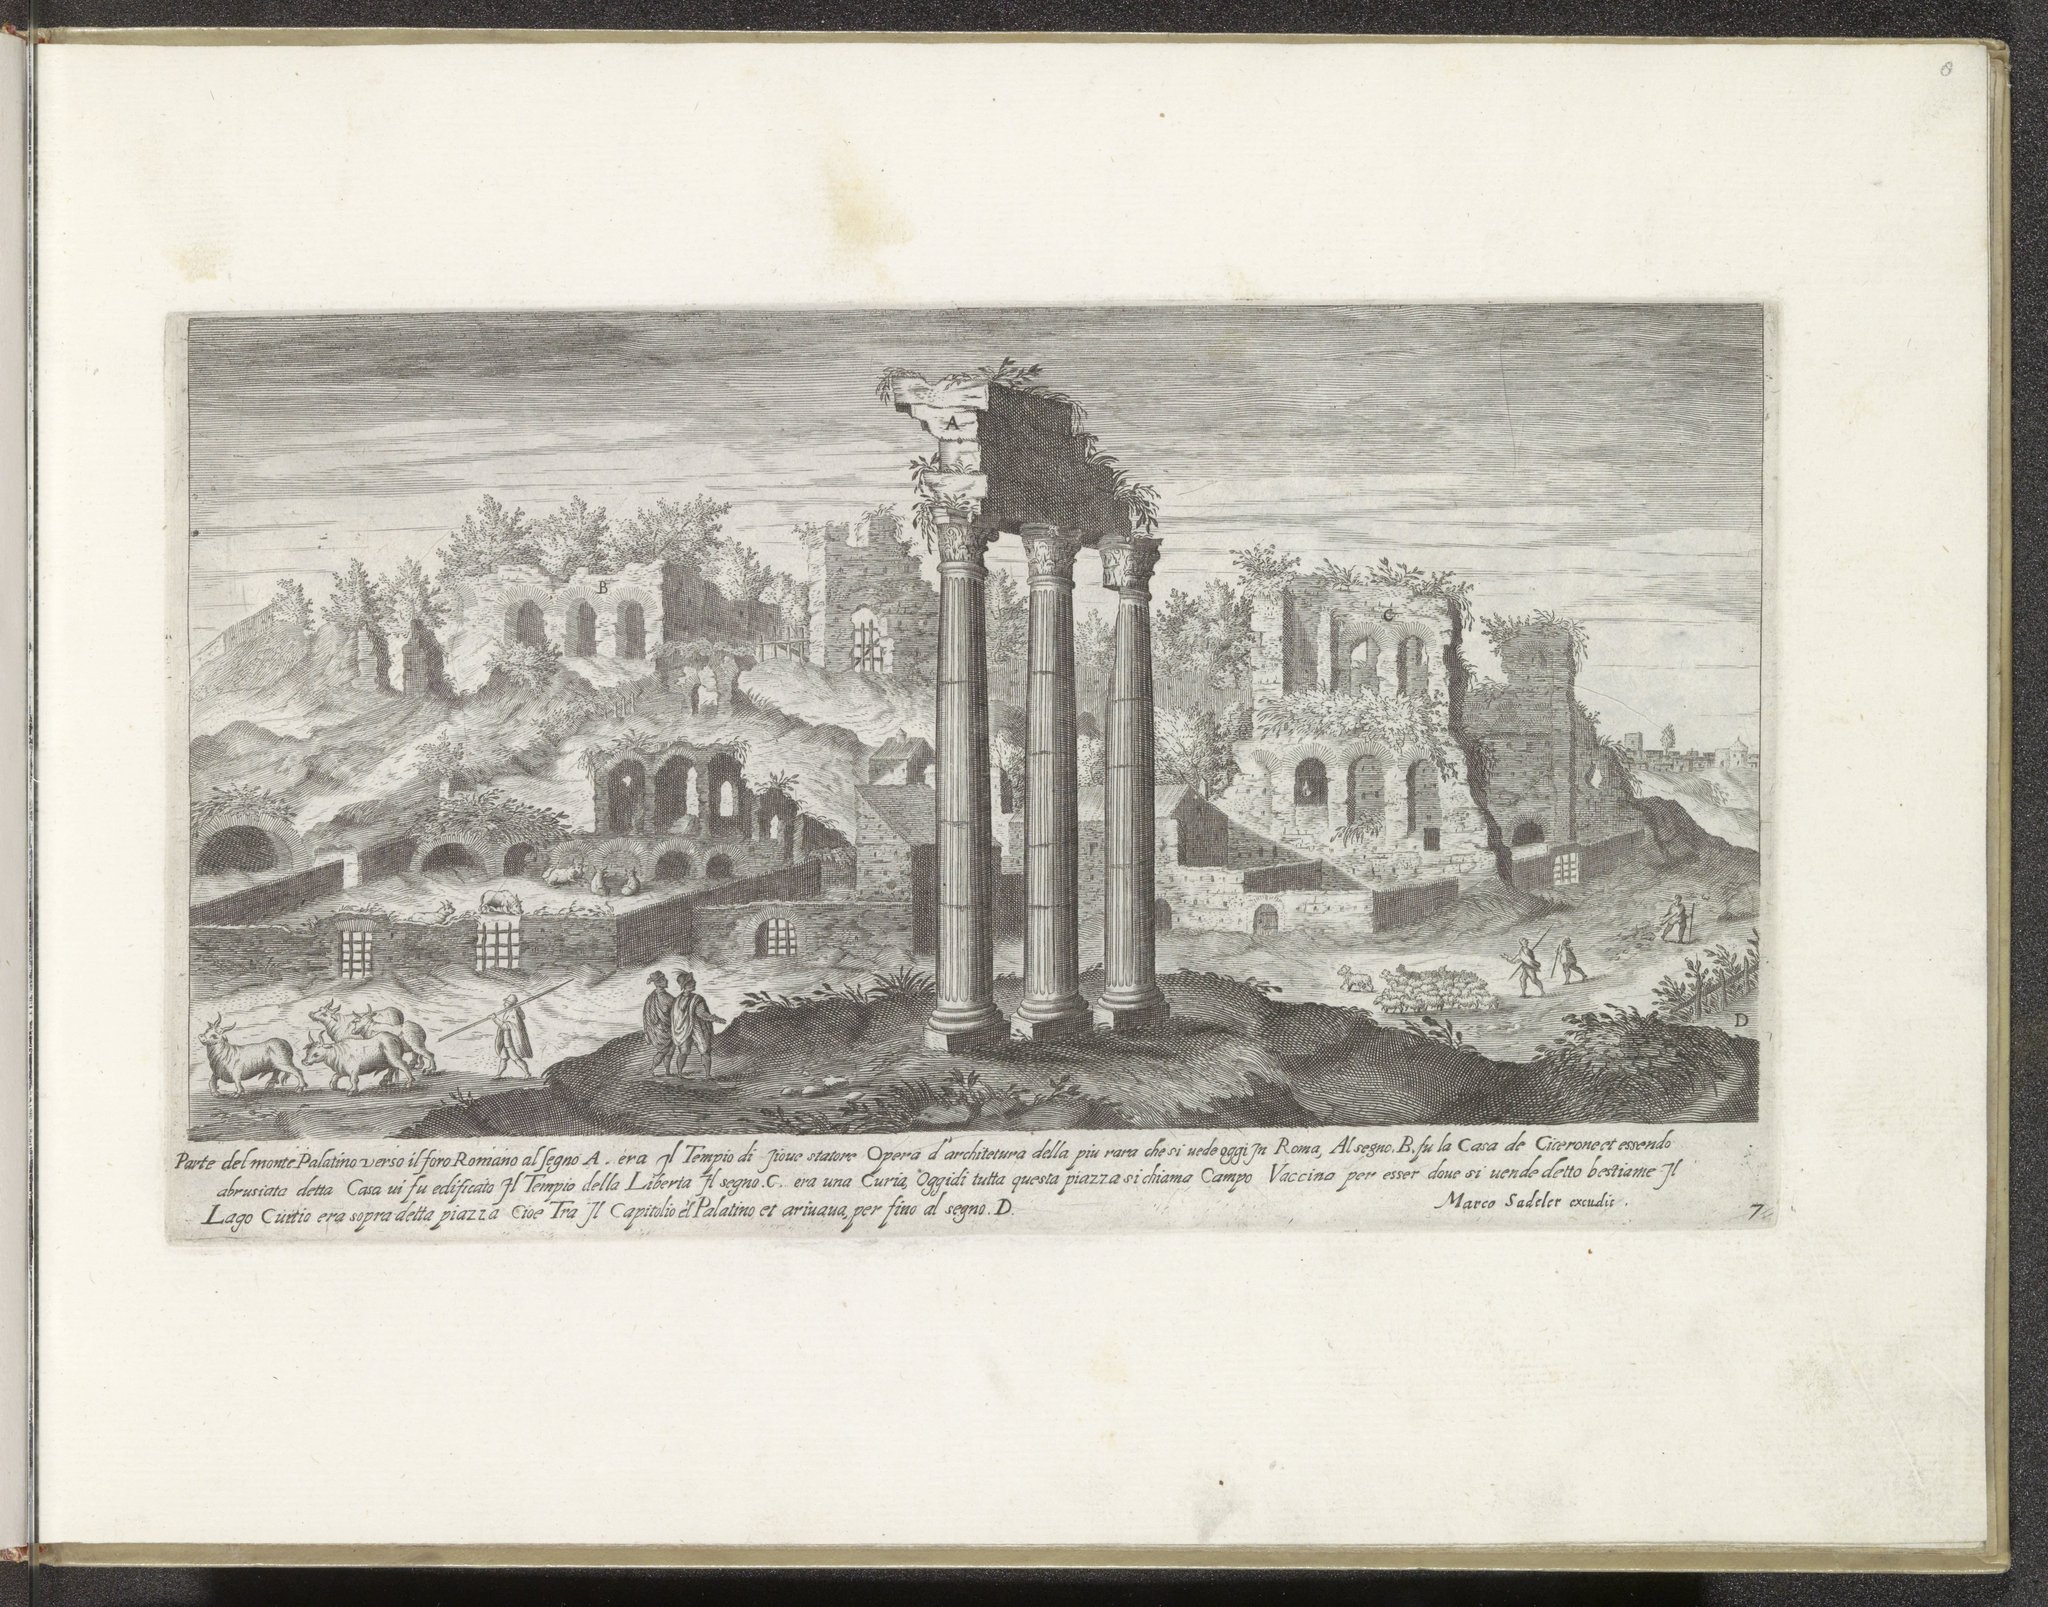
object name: print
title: Tempel van Jupiter Stator met de Tempel van Jupiter Stator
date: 1606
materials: paper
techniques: engraving, etching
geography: prague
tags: tempel van castor en pollux (rome), palatijn, tempel van jupiter stator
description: Gezicht op de ruïnes op de hellingen van de Palatijn, vanaf het Forum Romanum. Op de voorgrond de overblijfselen van de Tempel van Jupiter Stator, nu beter bekend als de tempel van Castor. Op de voorgrond figuren, een herder met zijn schapen en een herder met zijn stieren of ossen. In de ondermarge drie regels tekst in het Italiaans. De prent maakt deel uit van een album.